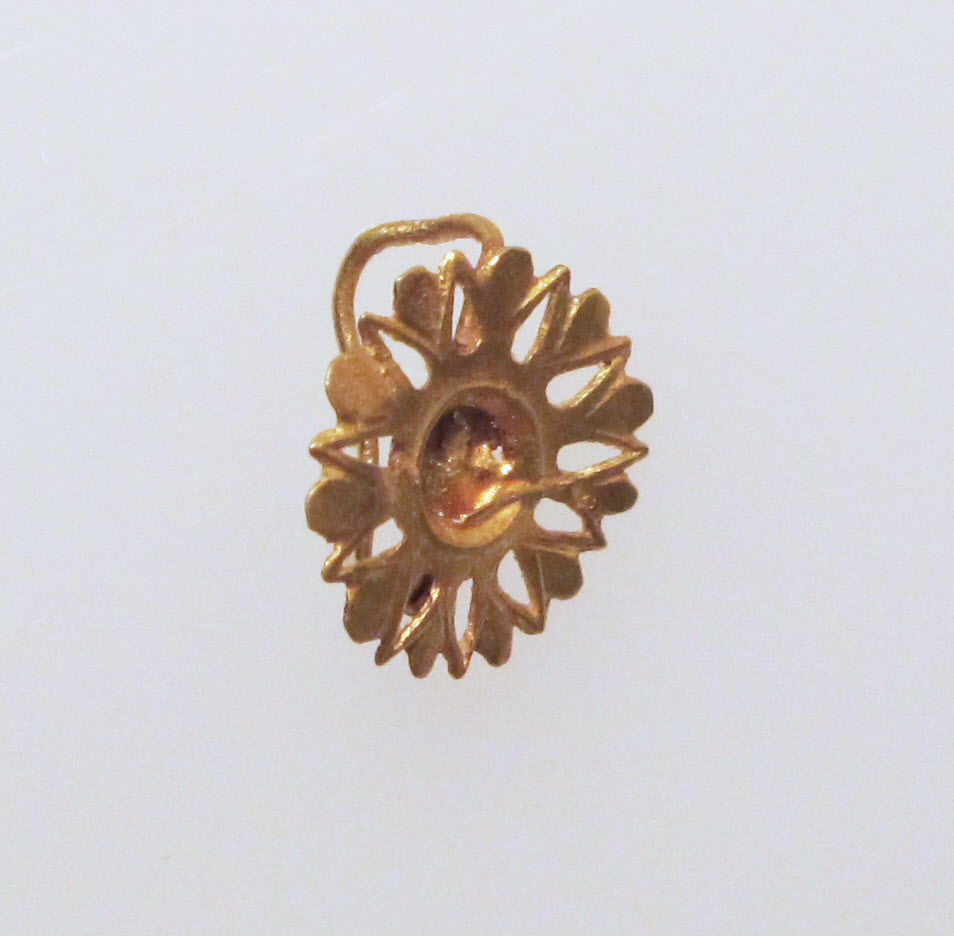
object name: earring with disc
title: Gold earring with rosette disk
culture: roman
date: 201-300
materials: gold